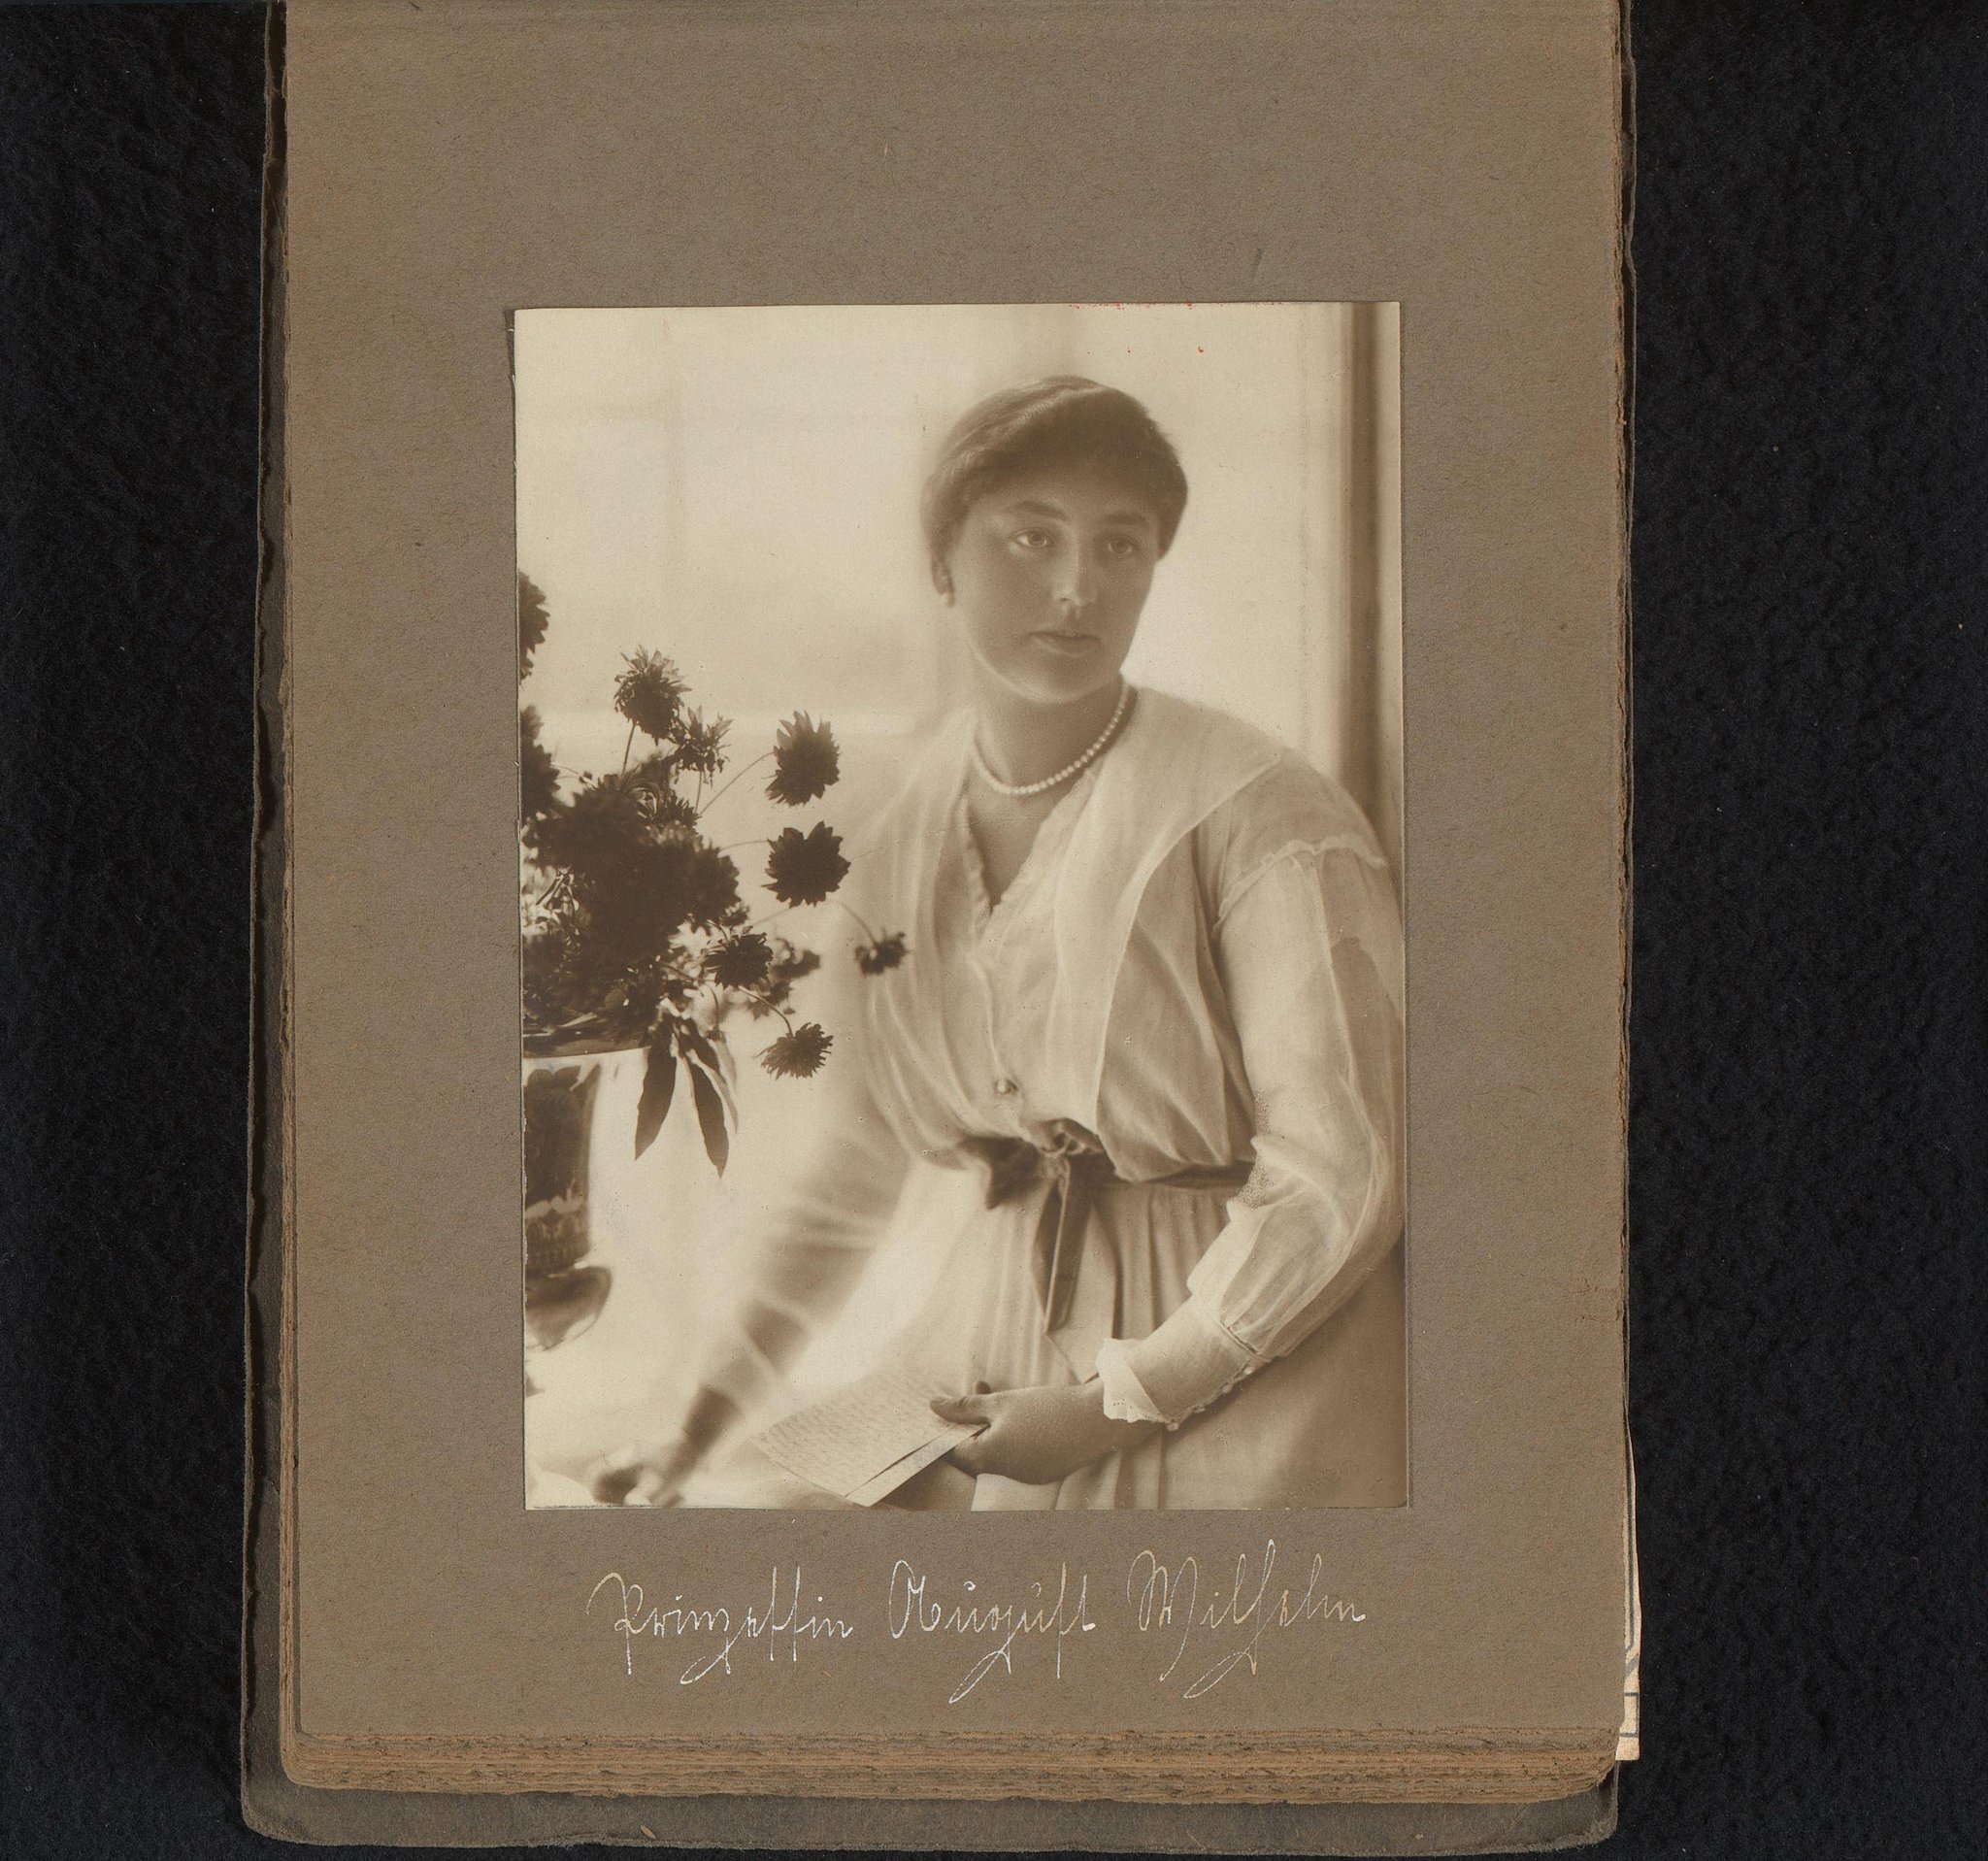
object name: album leaf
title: Prinzessin August Wilhelm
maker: Anonymous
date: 1910-1917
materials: paper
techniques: gelatin silver print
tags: historical persons, princess